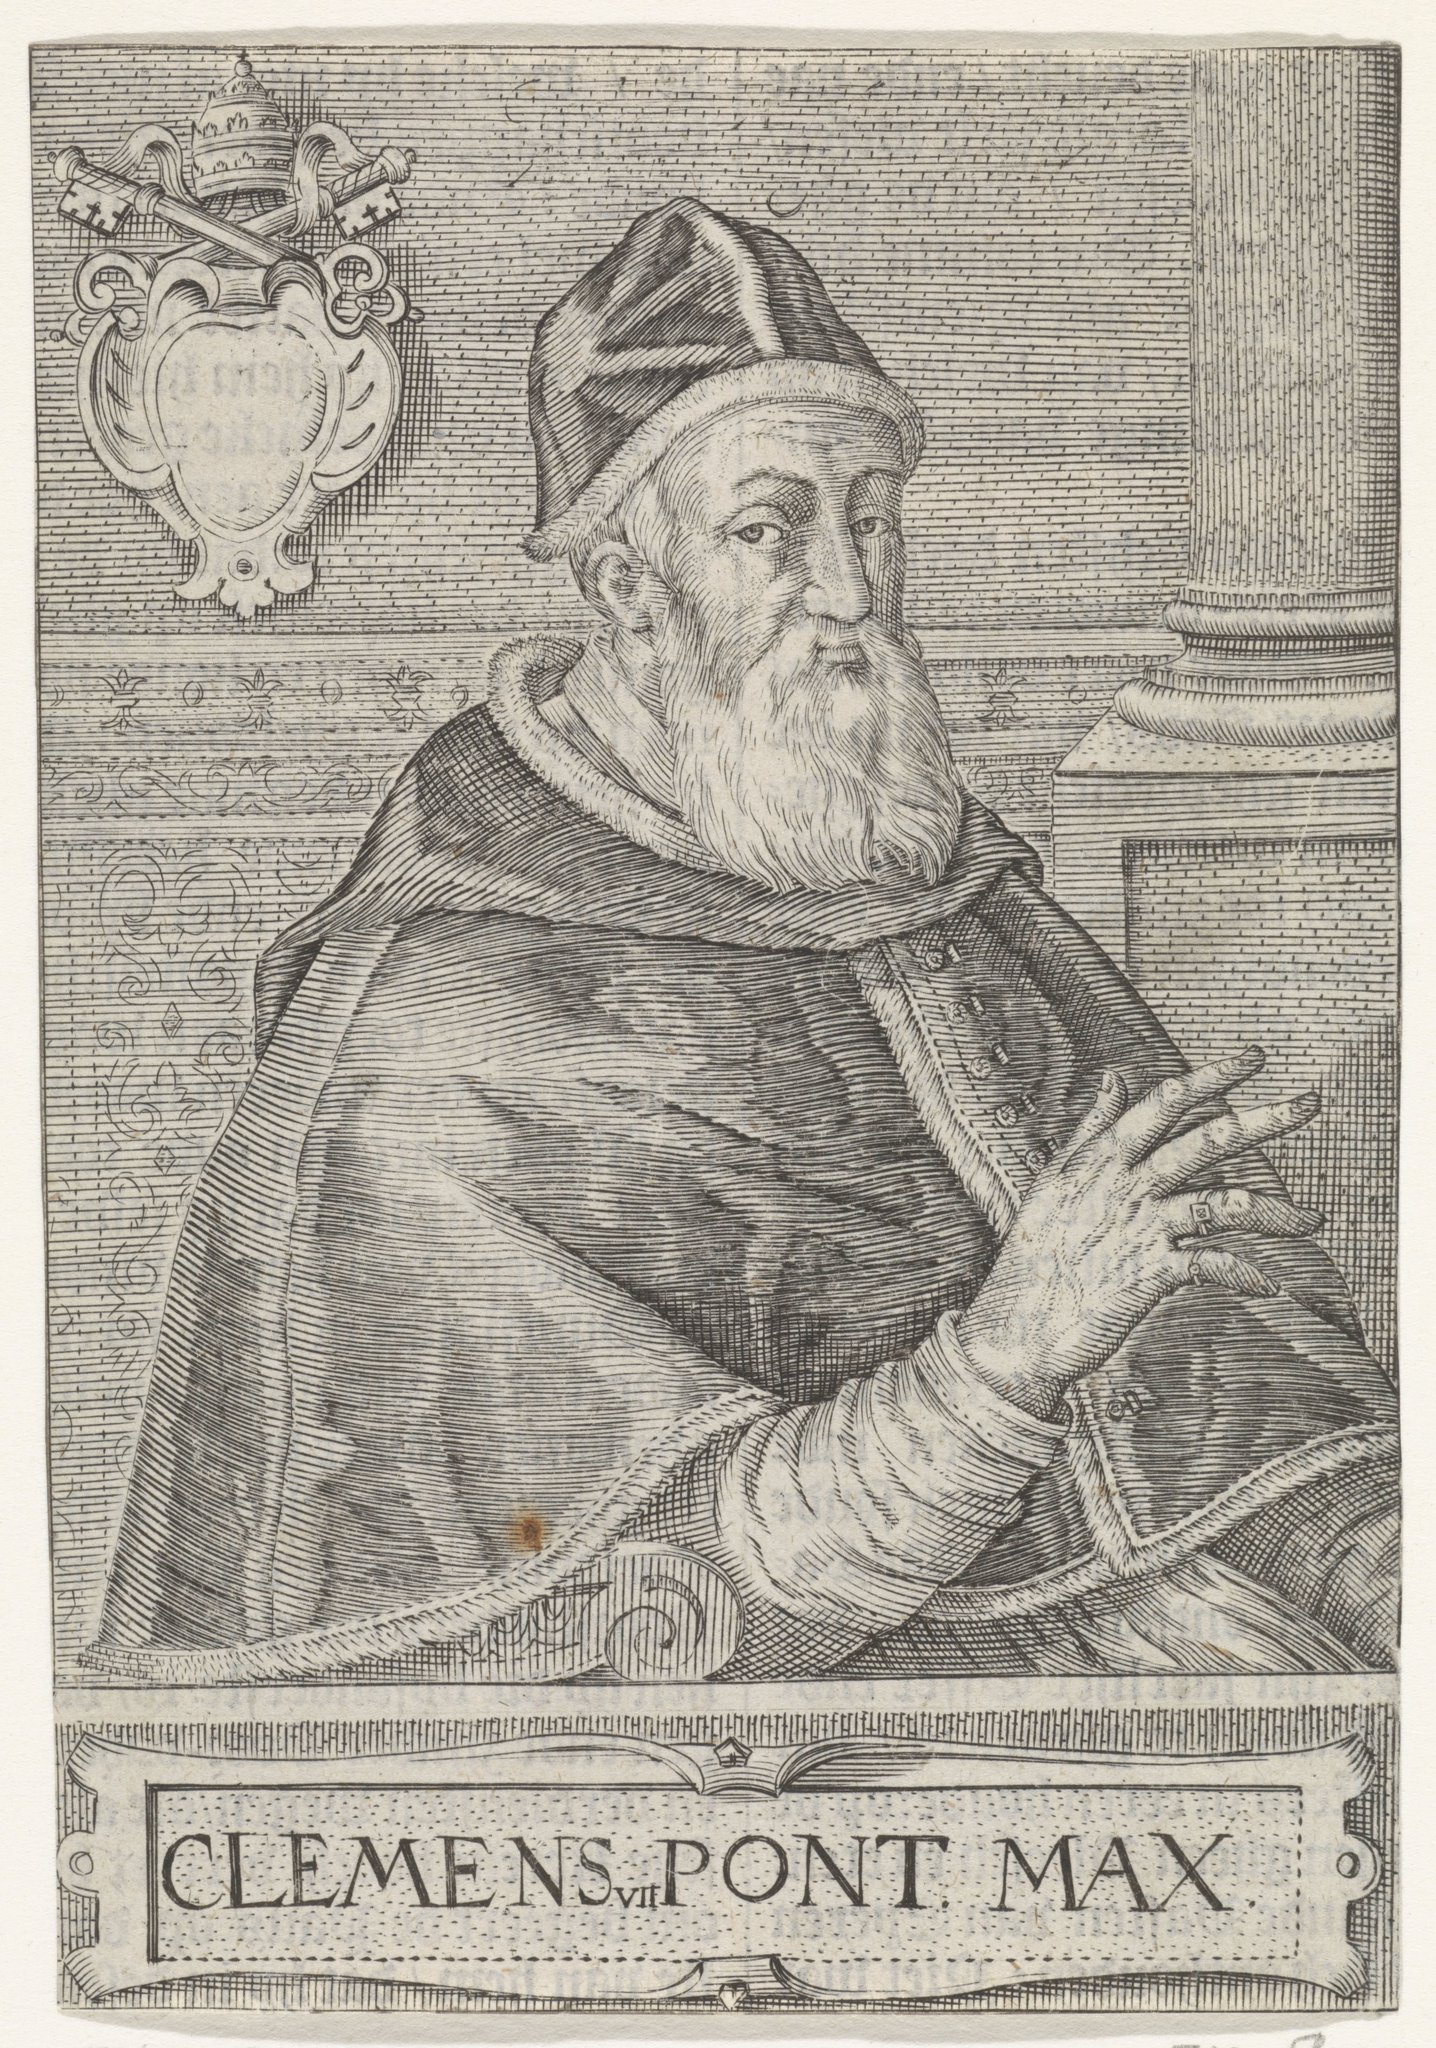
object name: book illustration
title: Portret paus Clemens VII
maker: Anonymous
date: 1605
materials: paper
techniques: engraving, letterpress printing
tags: rome, pope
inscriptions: date